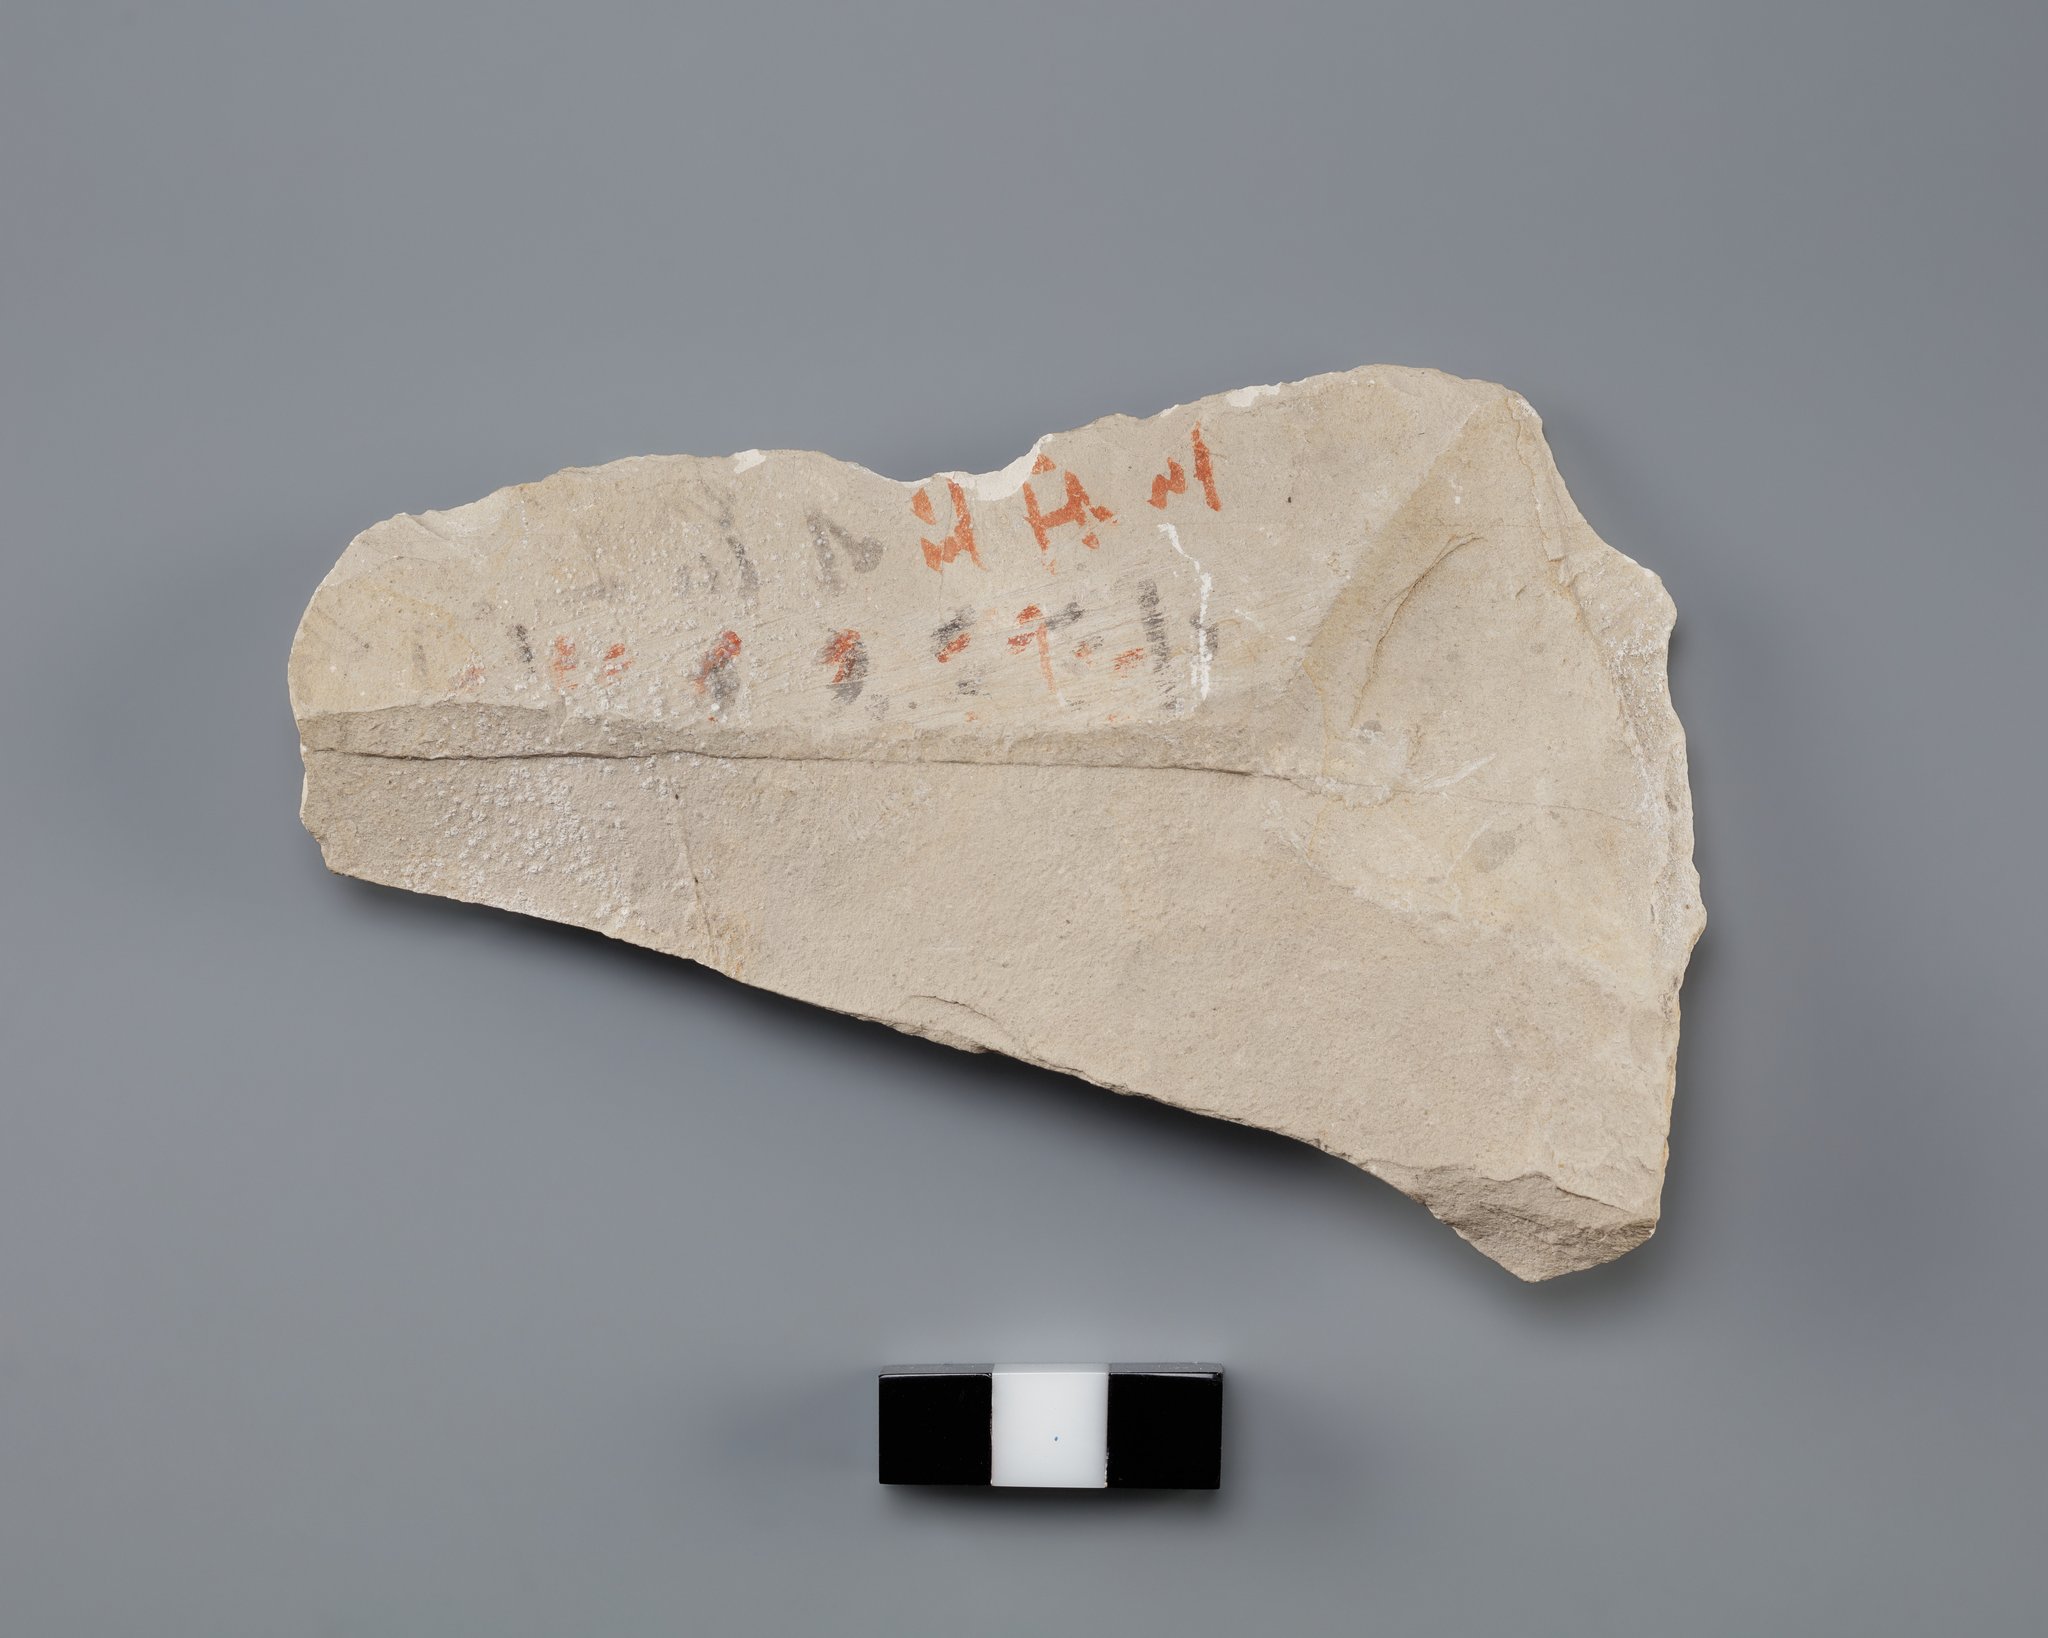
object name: ostracon, hieratic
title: Hieratic ostracon with short list in red and black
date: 1295-1070 BCE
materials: ink, limestone, paint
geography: egypt